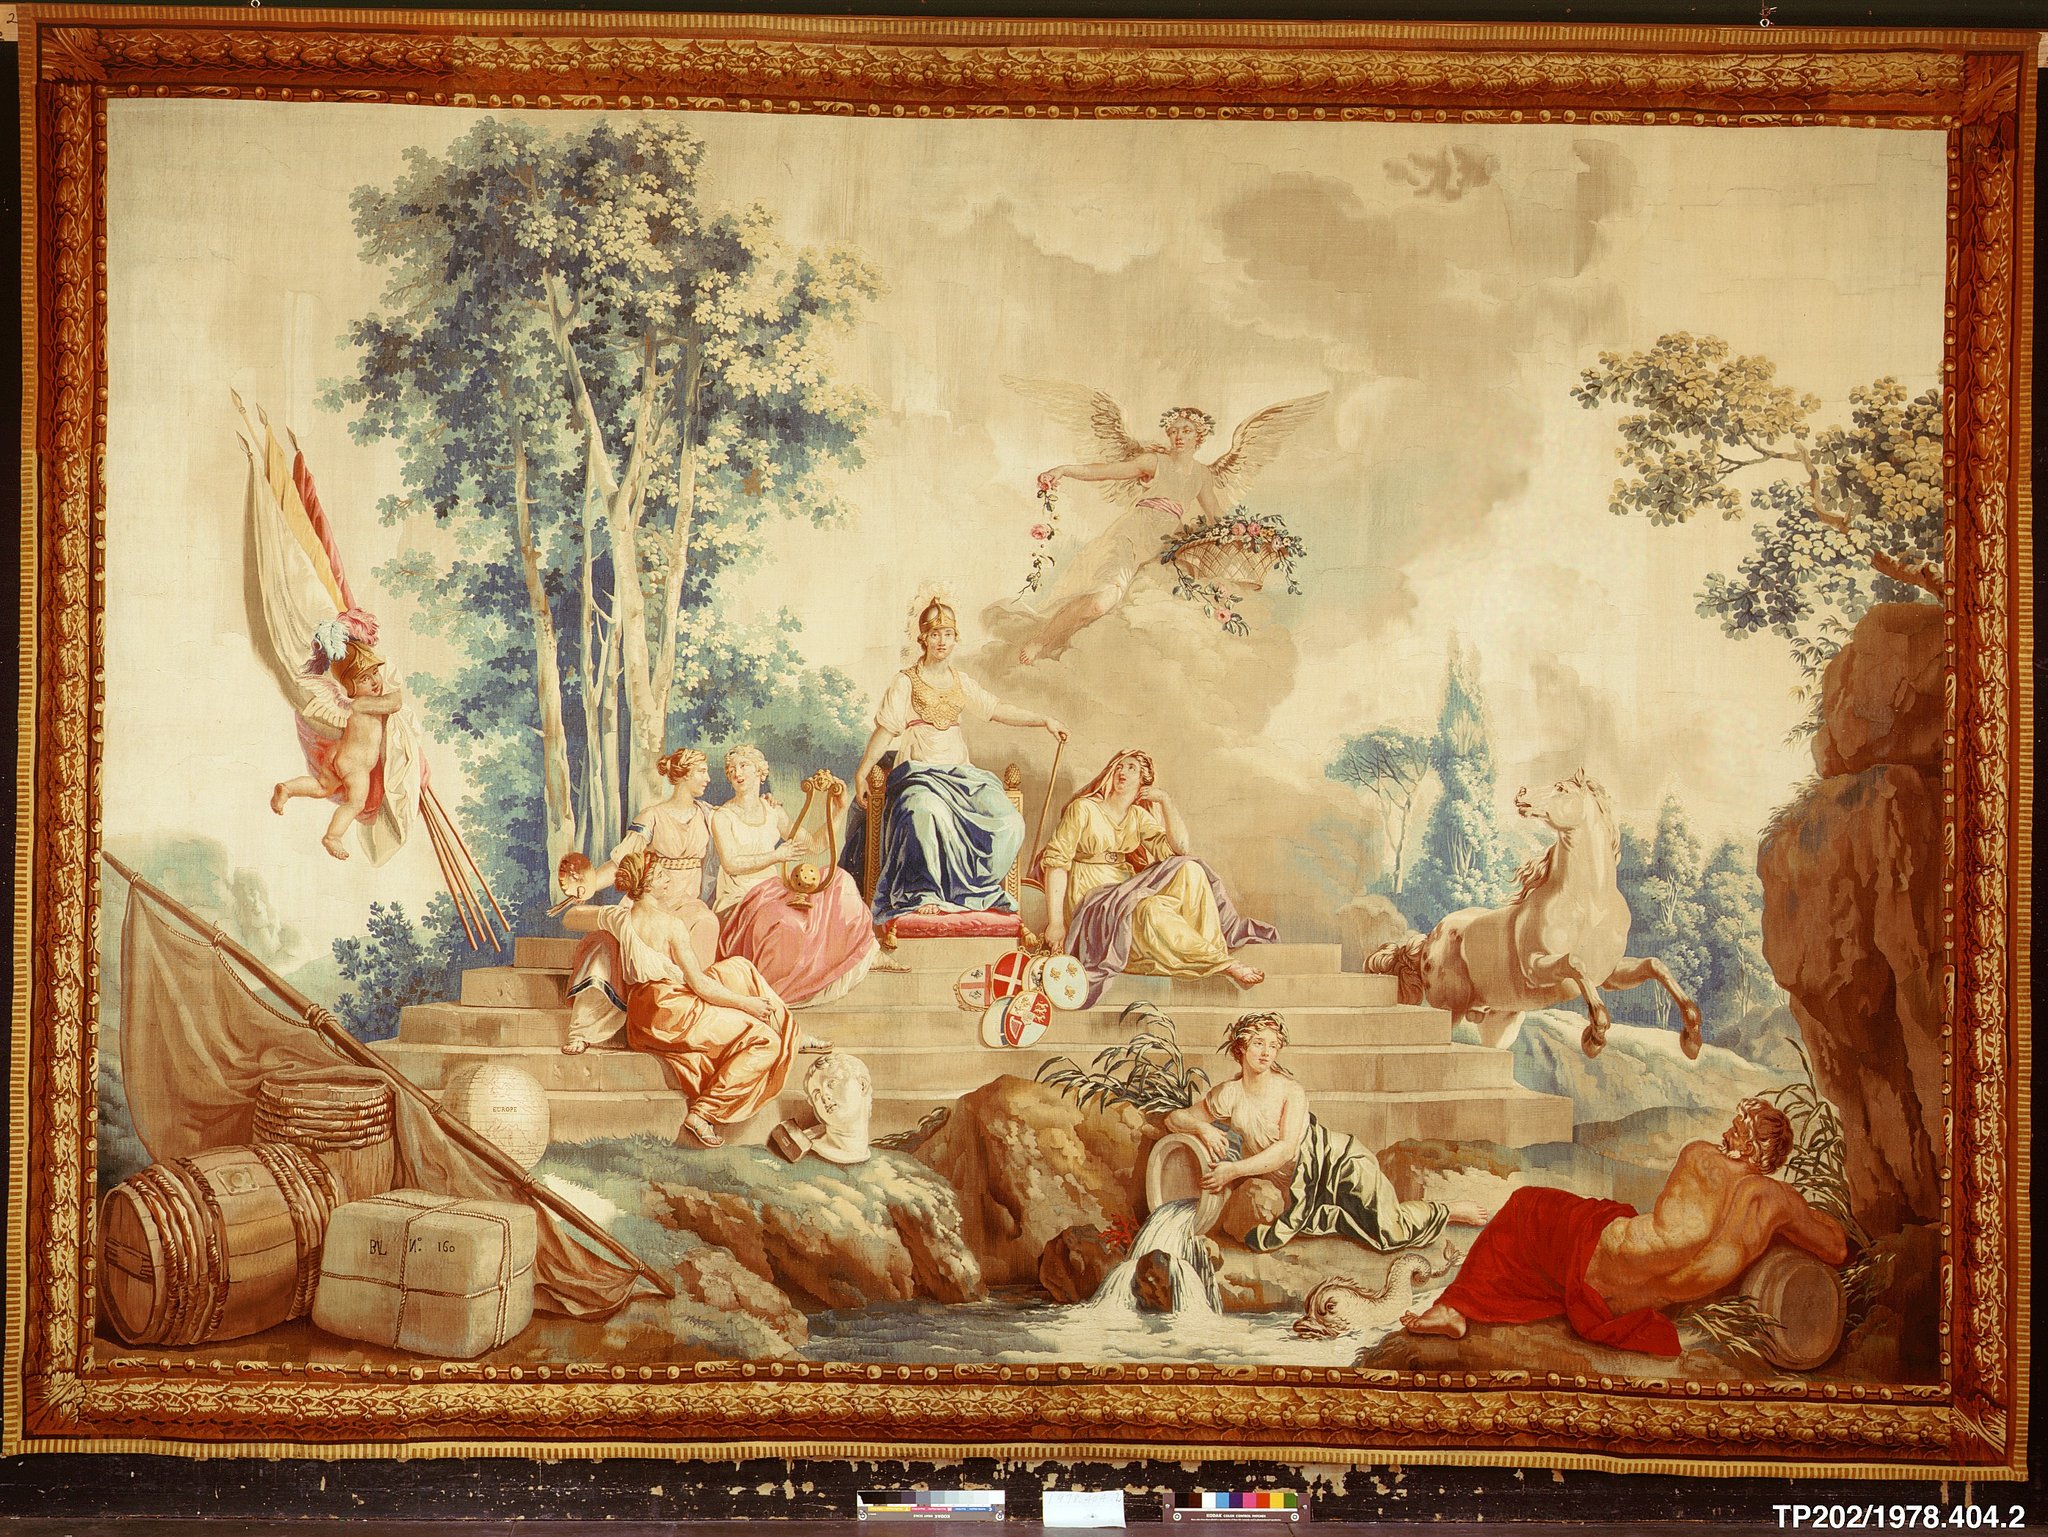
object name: tapestry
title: Europe from a set of The Four Continents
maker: jean jacques françois le barbier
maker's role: designer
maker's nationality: french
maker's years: 1738-1826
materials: silk, wool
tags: men,women,putti,minerva,fish,horses